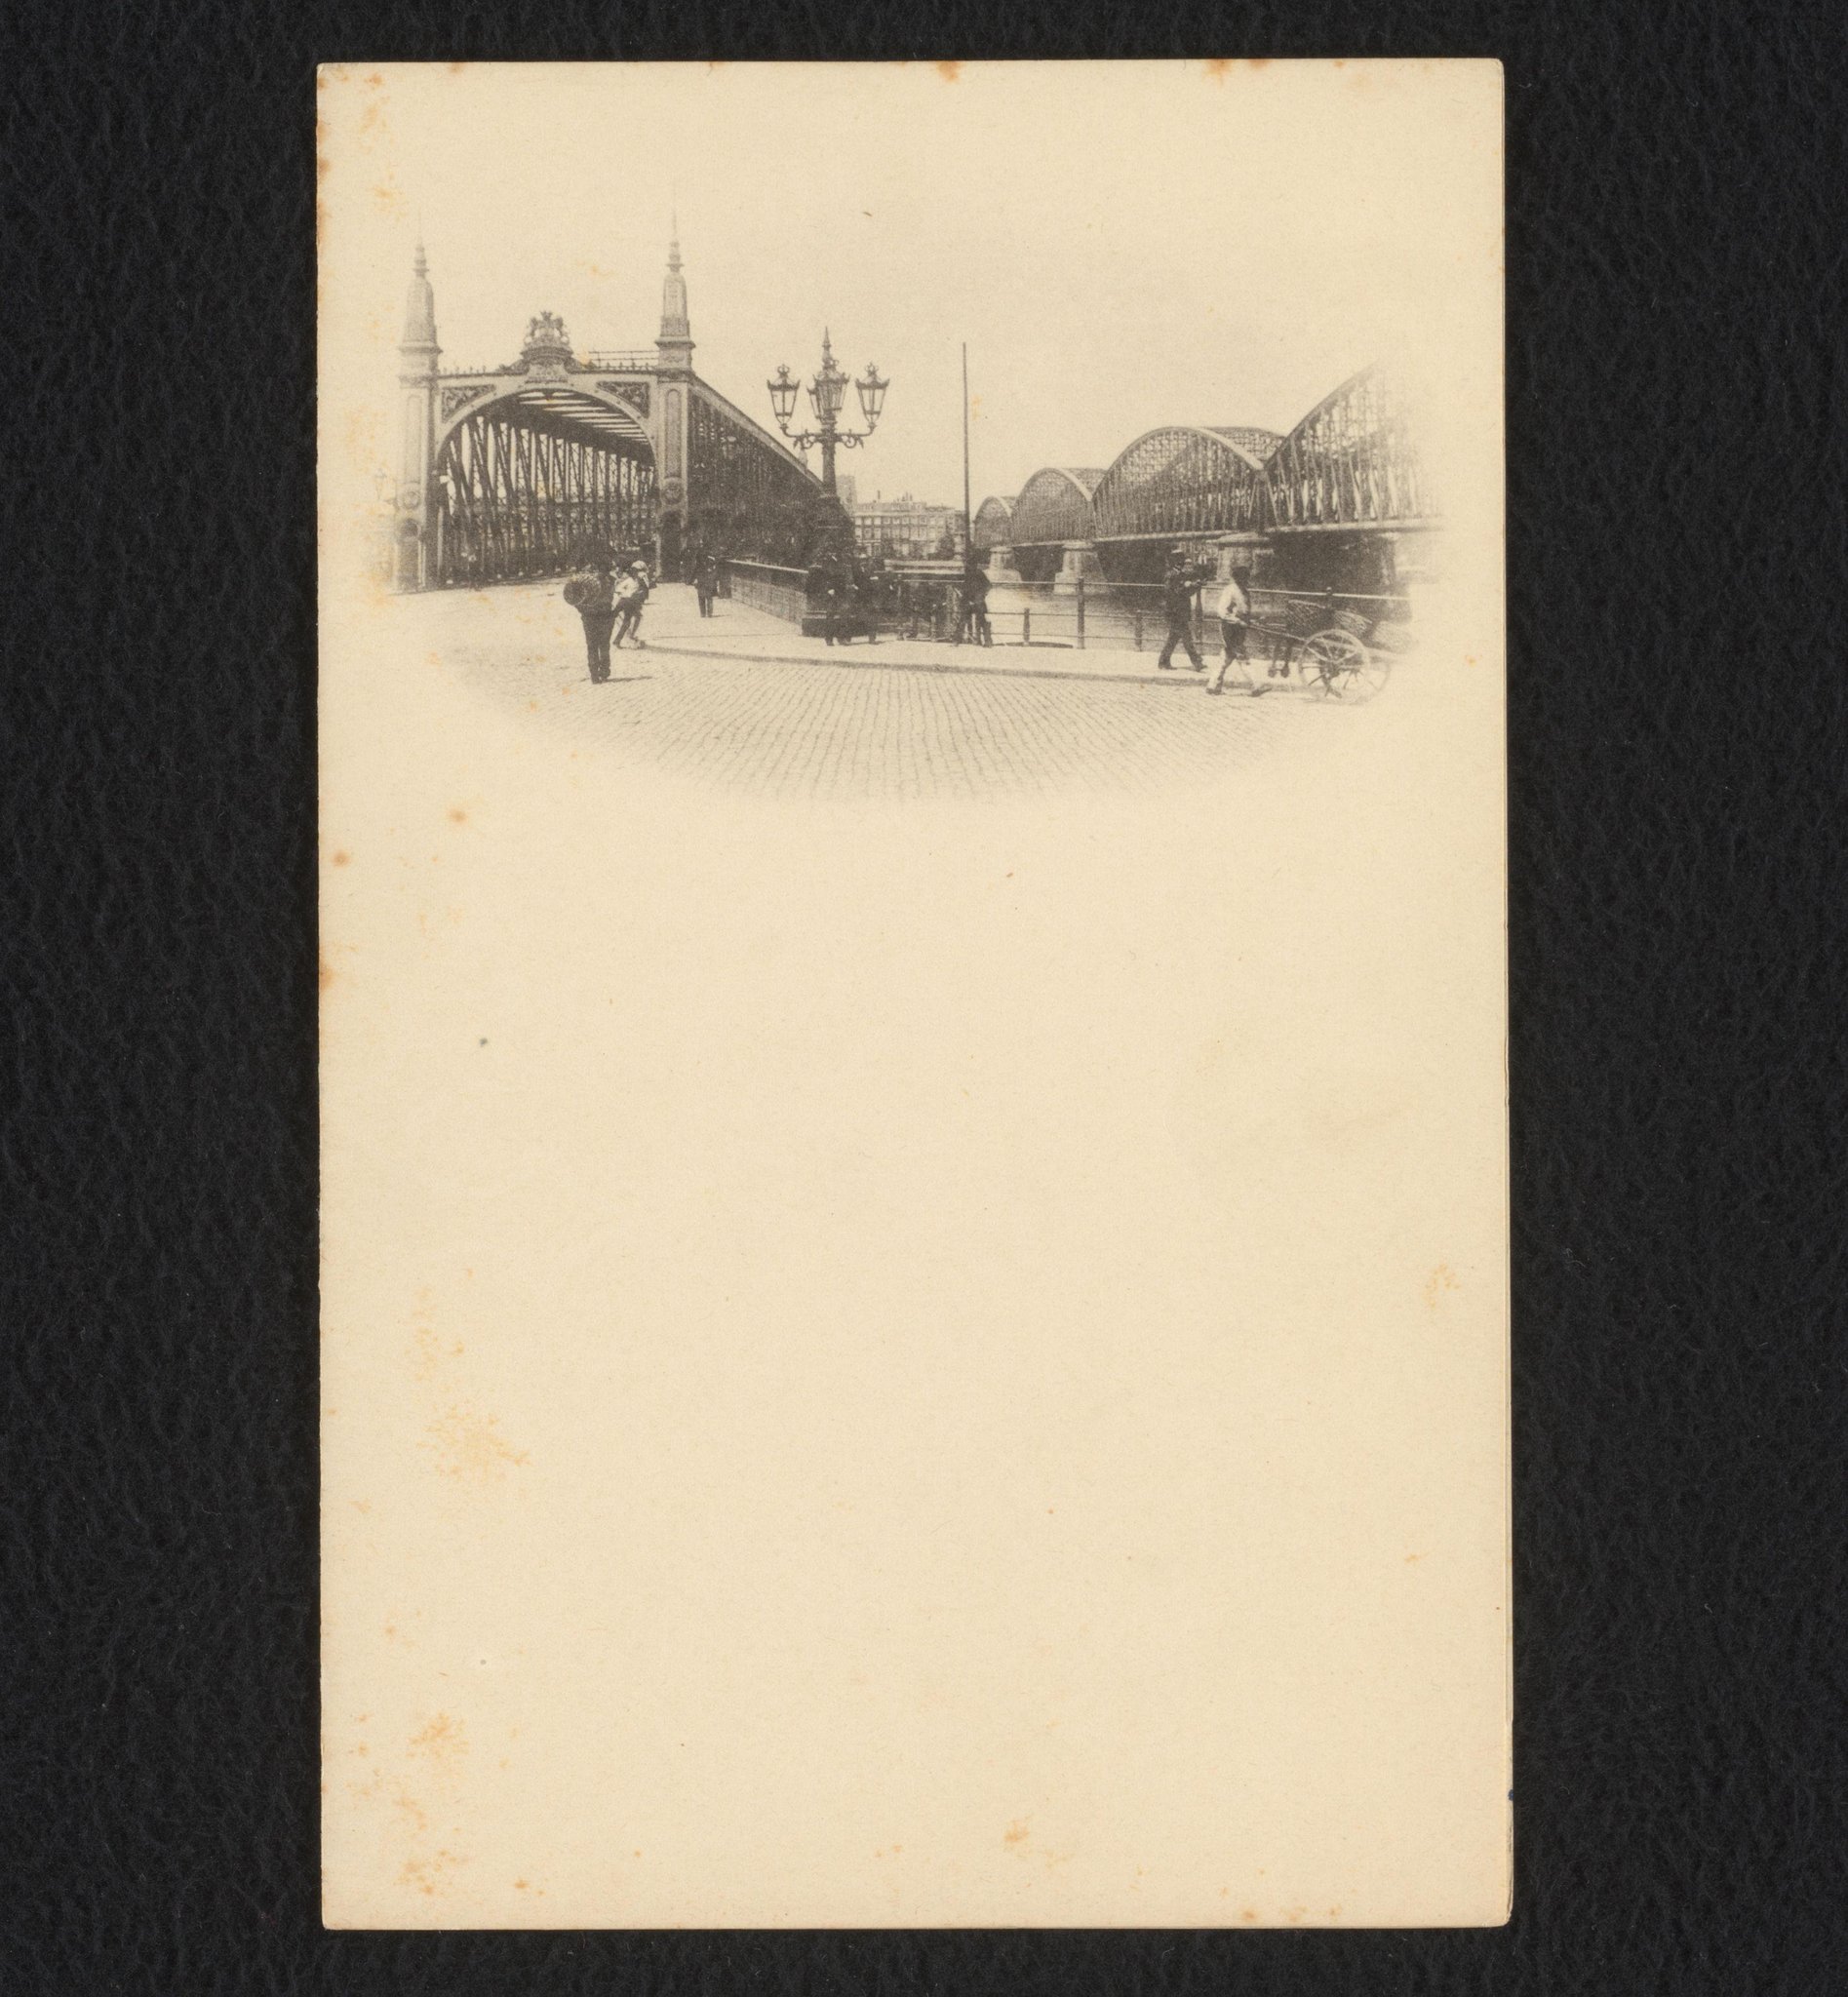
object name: stationery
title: Gezicht op de Willemsbrug en de spoorbrug over de Nieuwe Maas in Rotterdam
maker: Anonymous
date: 1890-1910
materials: paper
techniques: photograph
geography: rotterdam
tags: bridge in city across river, canal, etc.